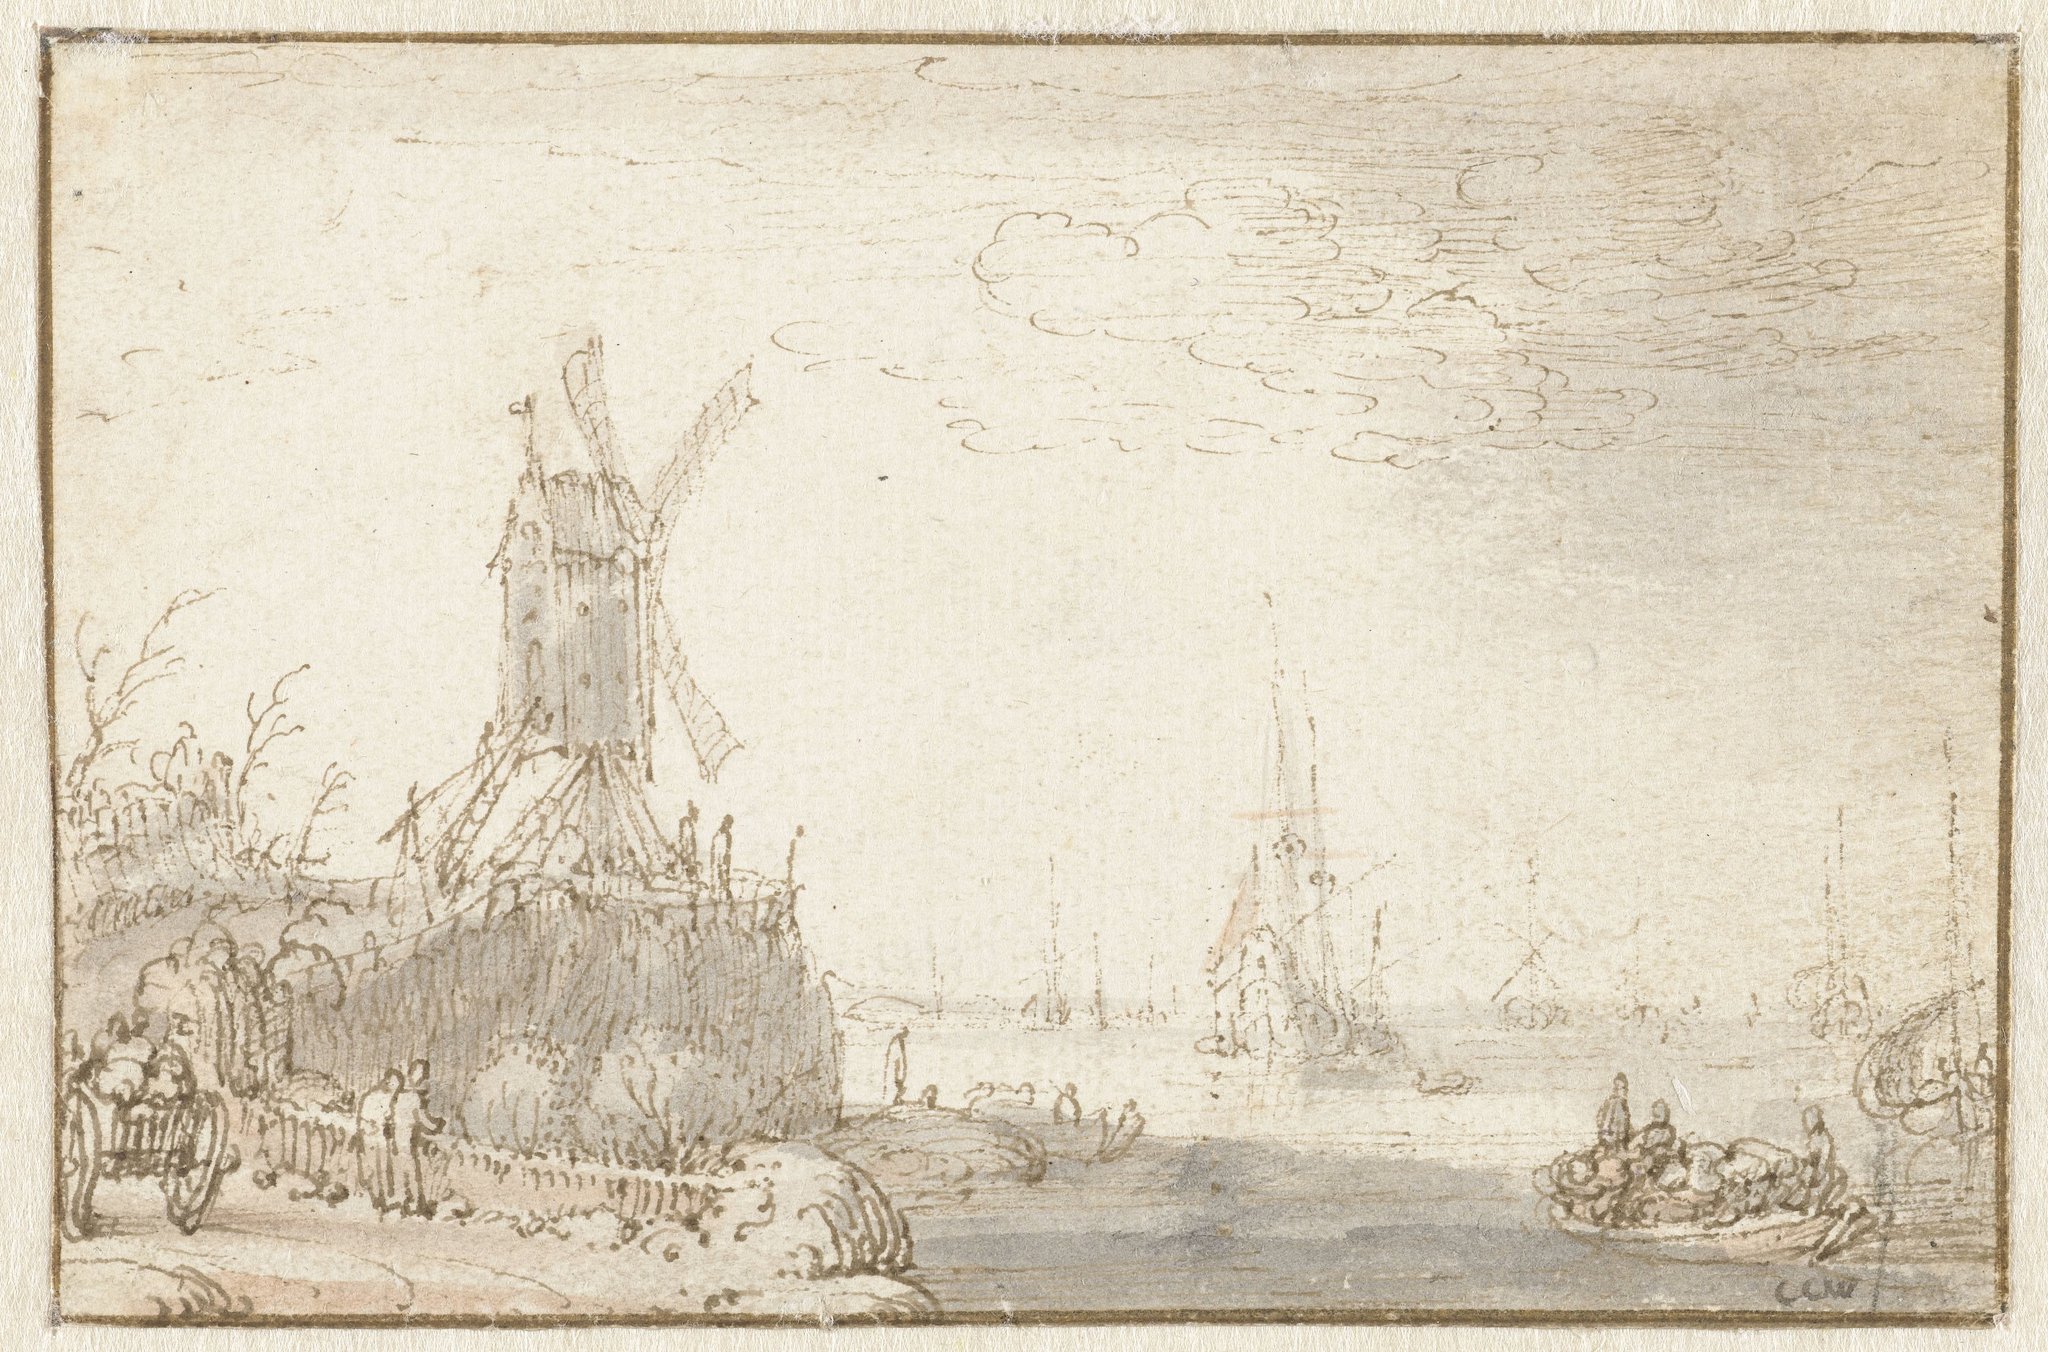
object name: drawing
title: Riviergezicht met windmolen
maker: cornelis claesz van wieringen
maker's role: draughtsman, painter, print maker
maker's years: 1577-1633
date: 1590-1633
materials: ink, paper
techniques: brush, pen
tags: river, windmill